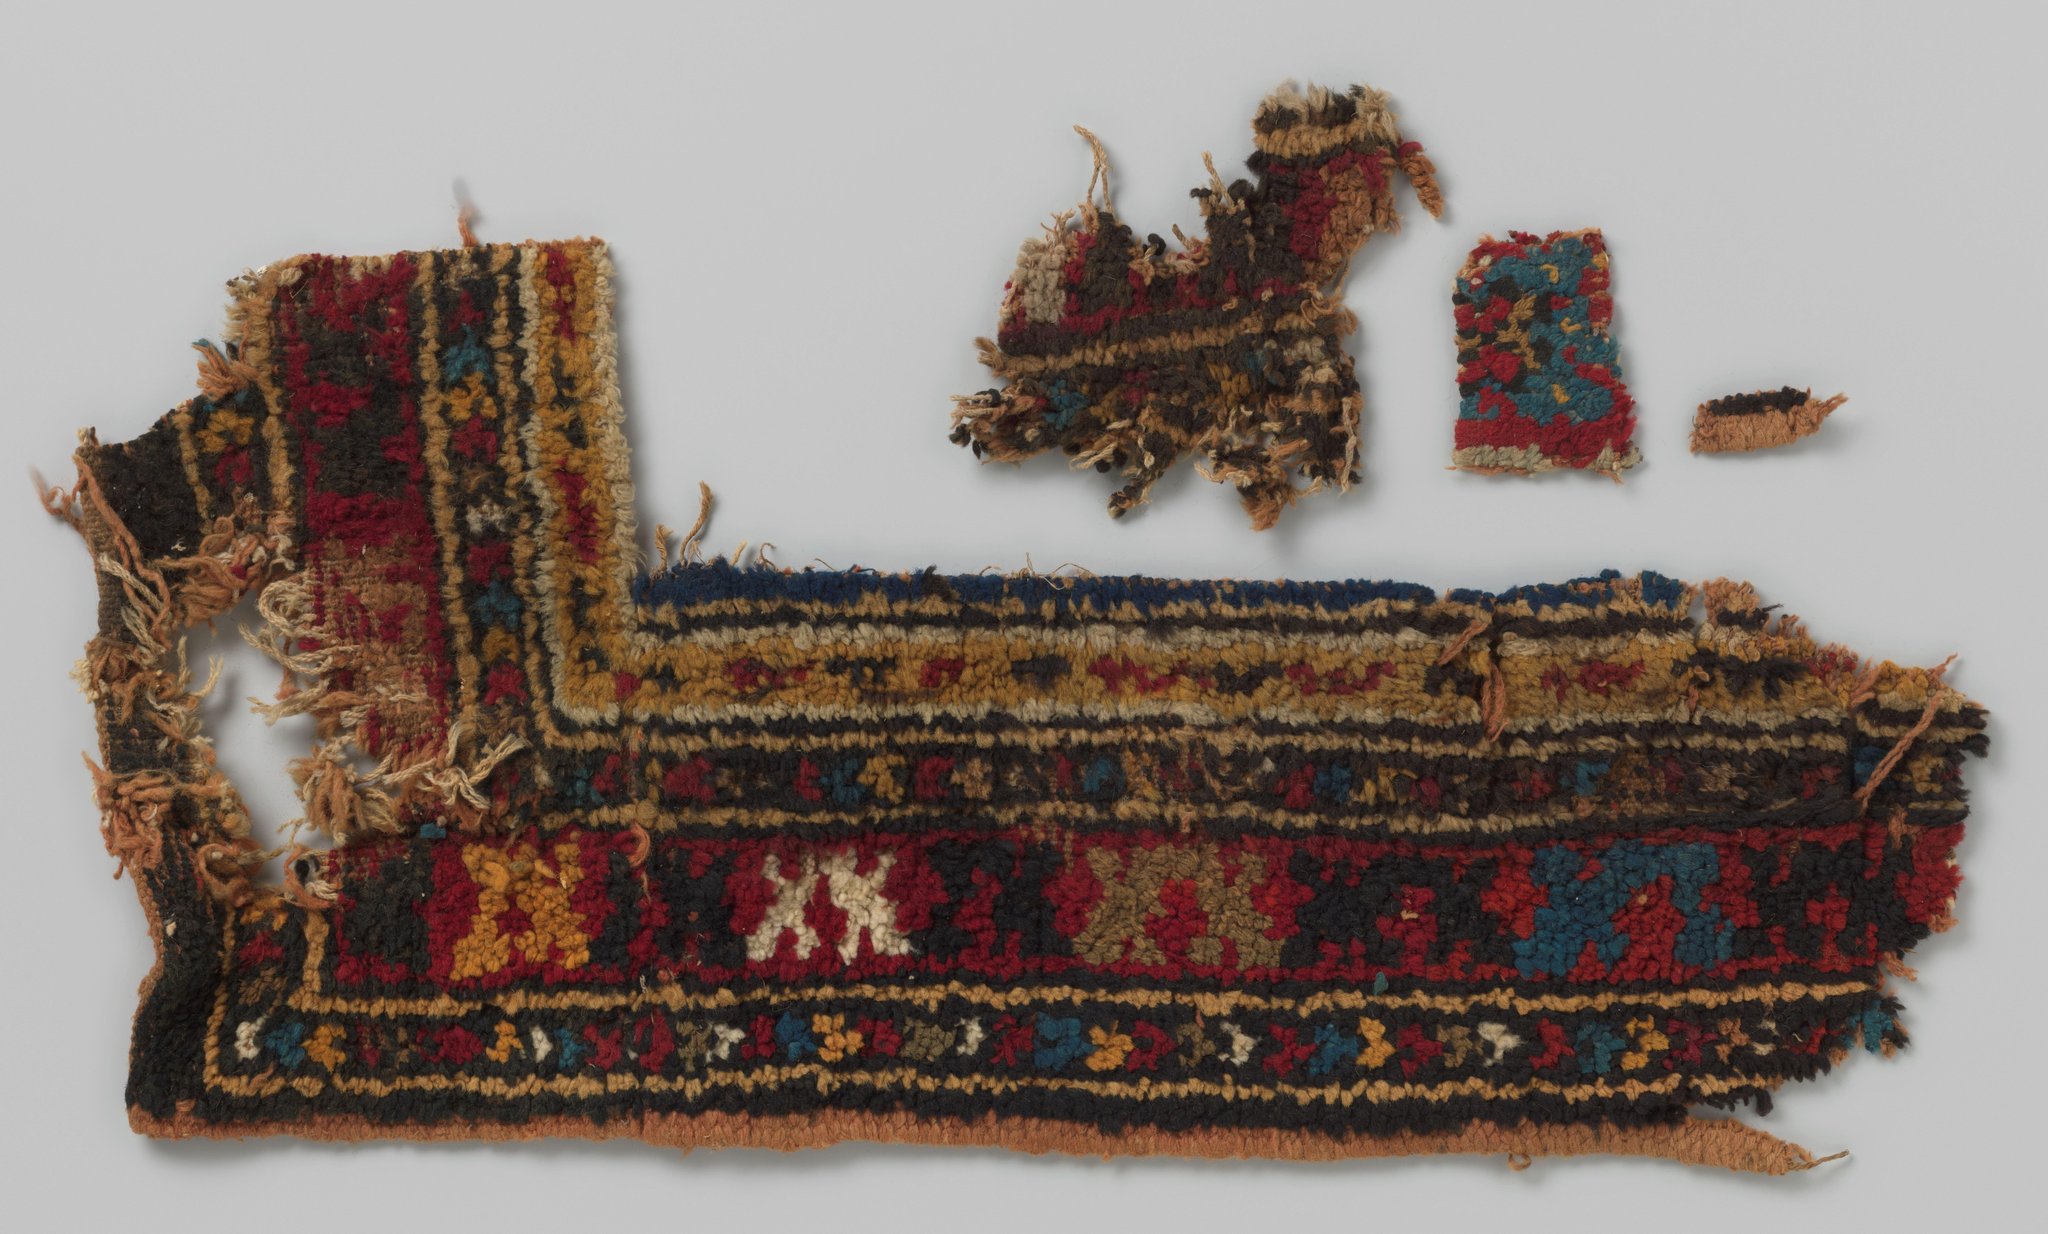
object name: fragment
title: Fragment van een tapijt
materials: wool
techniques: knotting, weave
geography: deventer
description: Fragment van een tapijt met randpatroon van randen met Oosters-geometrische (bloem)dessins.